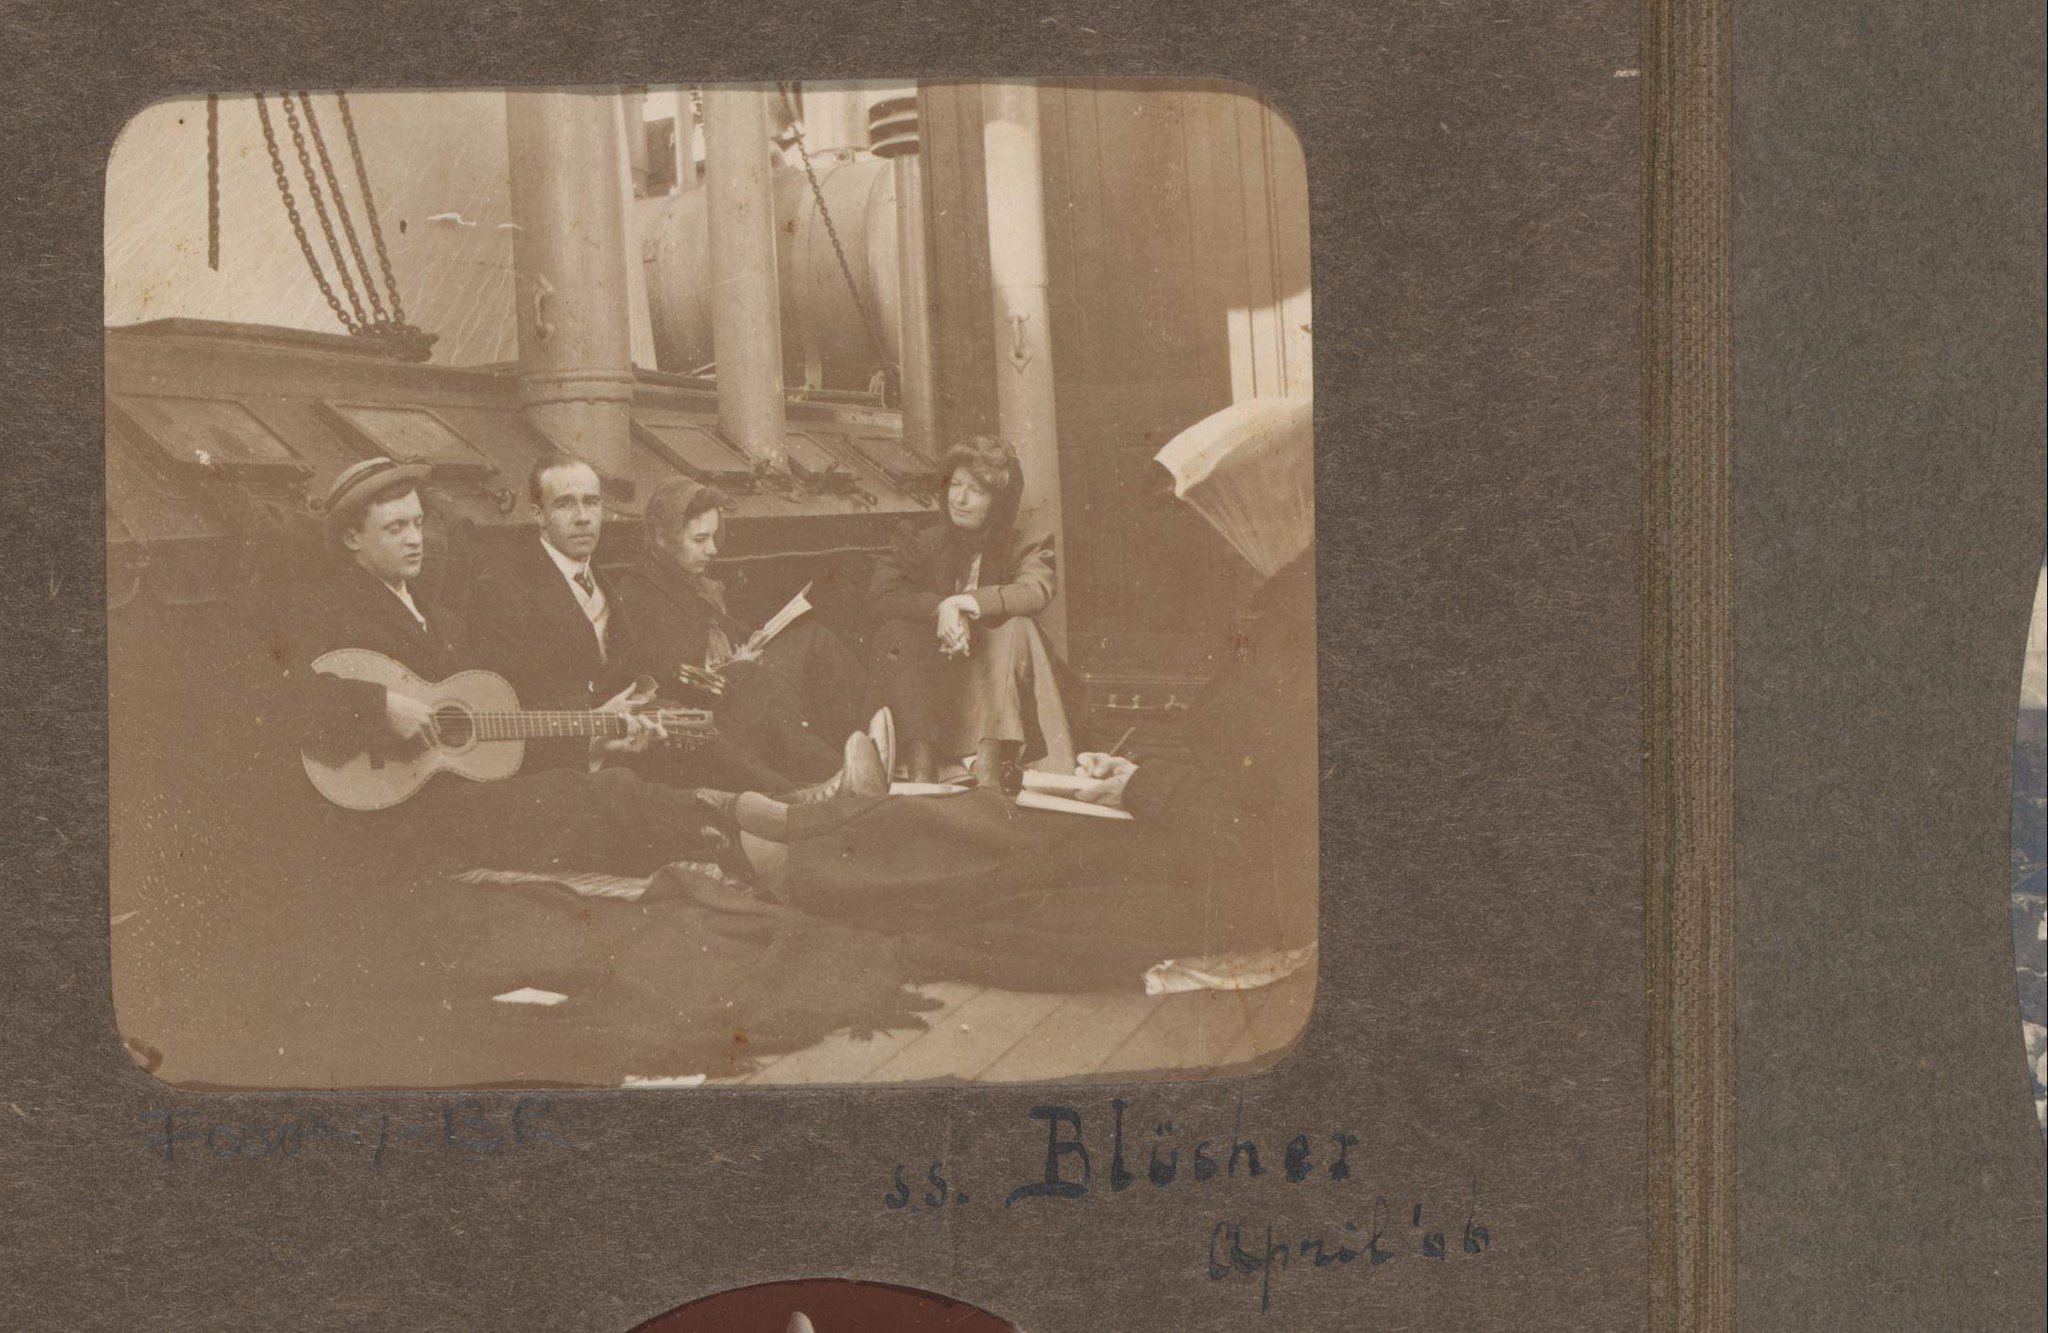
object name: photograph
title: Musicerend gezelschap aan boord van SS Blücher, vermoedelijk tussen Hamburg en New York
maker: Anonymous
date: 1904-1906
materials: cardboard, paper, photographic support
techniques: gelatin silver print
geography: atlantic ocean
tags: passenger liner, making music; musician with instrument - cc - out of doors, atlantic ocean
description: Onderdeel van Reisalbum van een Nederlandse familie met bezienswaardigheden in Europa, Egypte en New York.